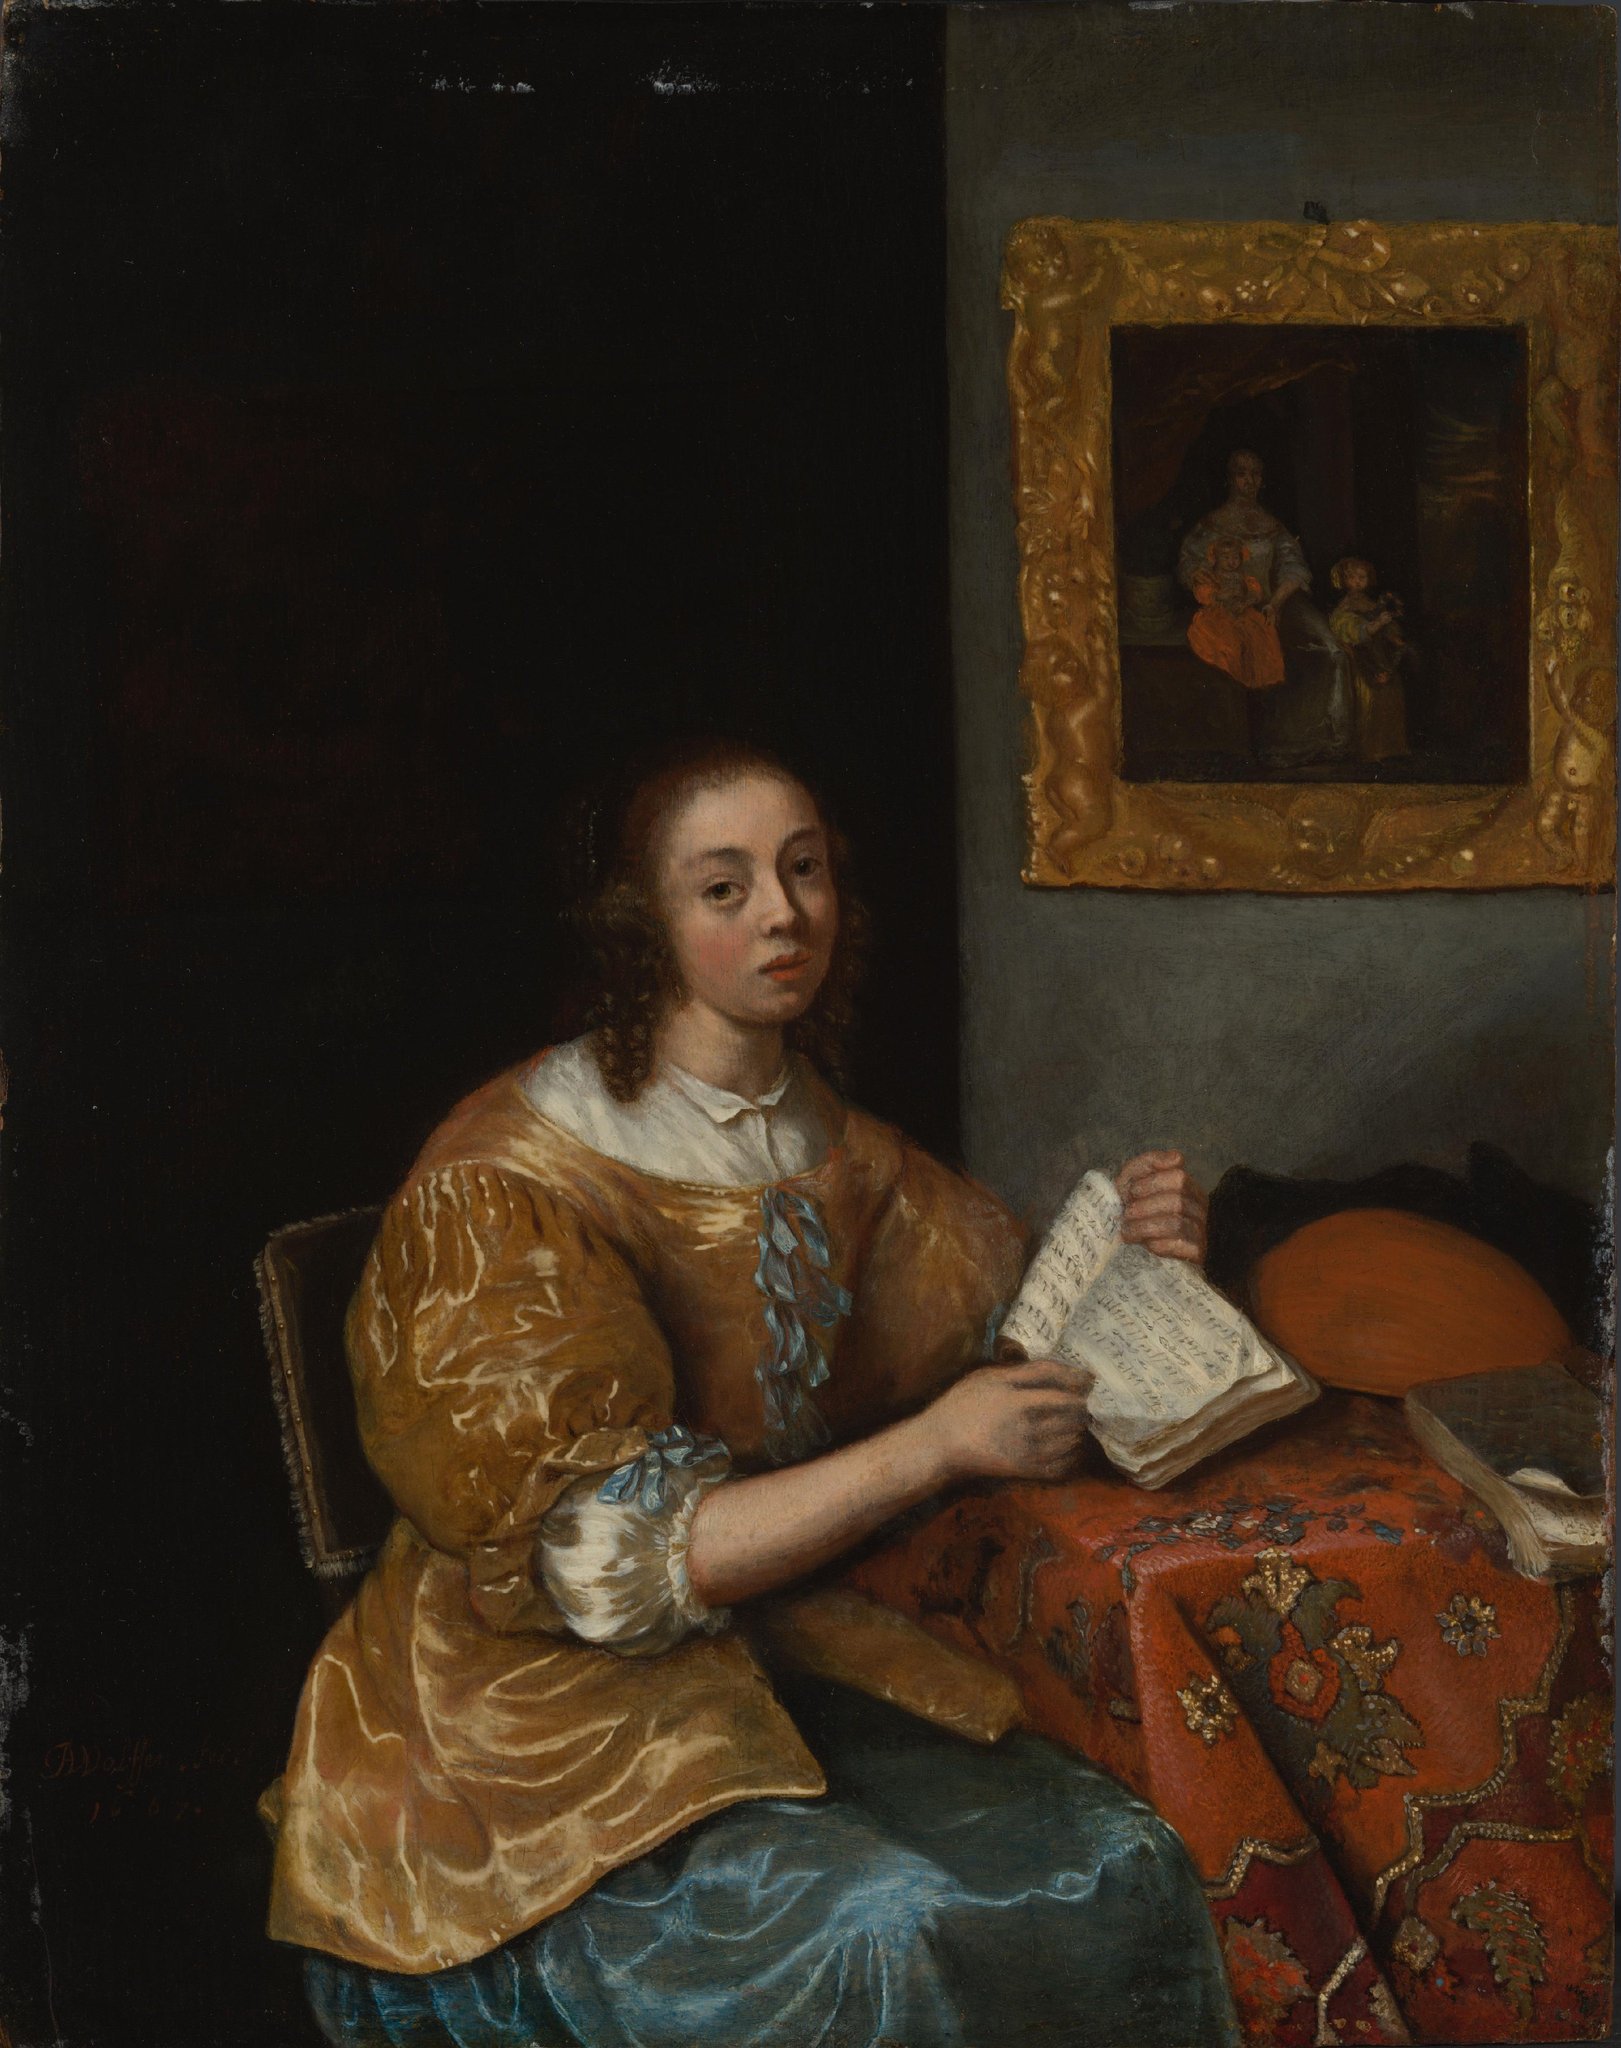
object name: painting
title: Zittende vrouw in het geel met bladmuziek in de hand, naast haar een luit op de tafel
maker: aleijda wolfsen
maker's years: 1648-1692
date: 1667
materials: oil, paint, panel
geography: zwolle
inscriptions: signature and date: ‘A Wolfsen. fec/1667’